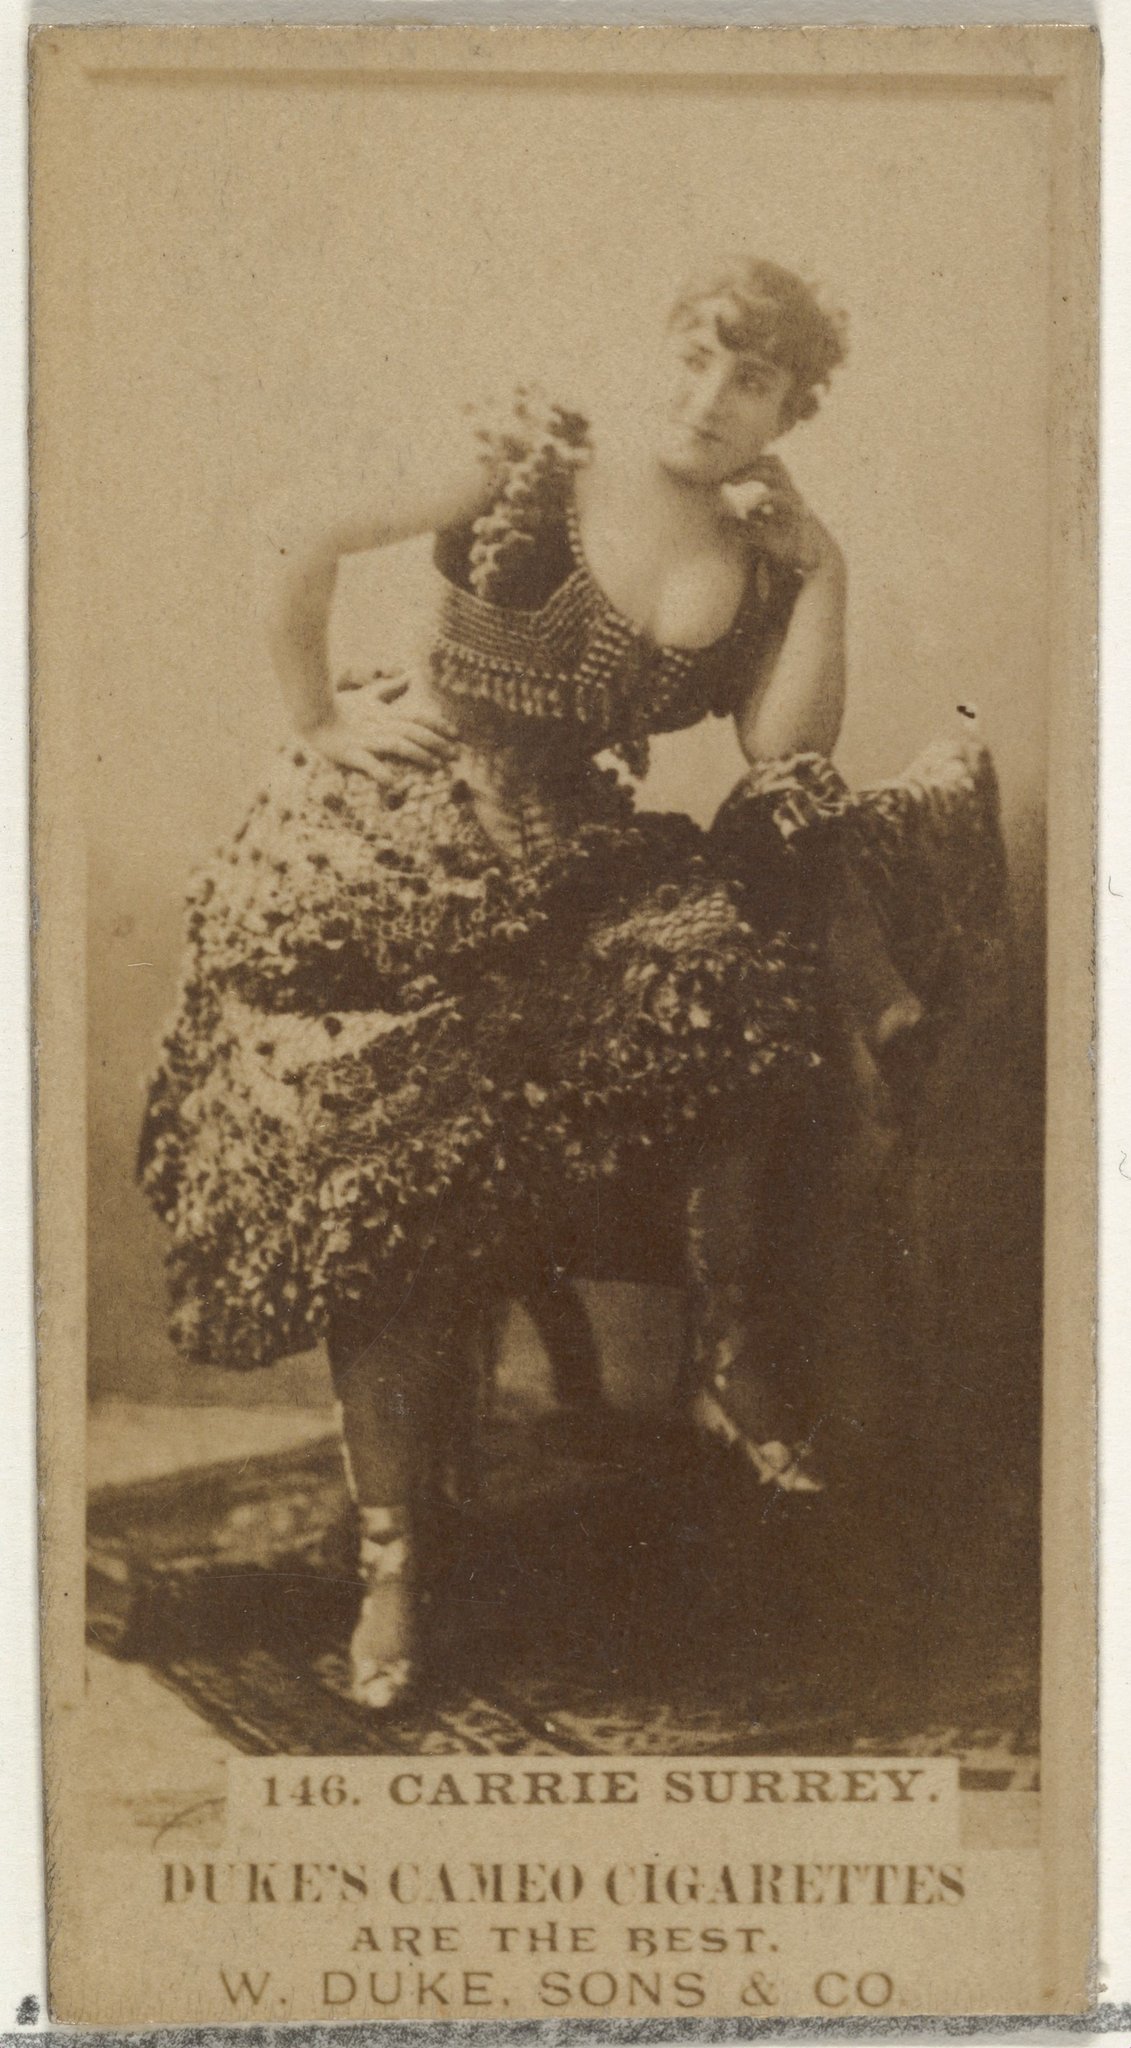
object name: photograph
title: Card Number 146, Carrie Surrey, from the Actors and Actresses series (N145-5) issued by Duke Sons & Co. to promote Cameo Cigarettes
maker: w. duke, sons & co.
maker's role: publisher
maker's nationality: american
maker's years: 1870-1920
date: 1880-1889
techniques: albumen silver print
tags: portraits,women,actresses